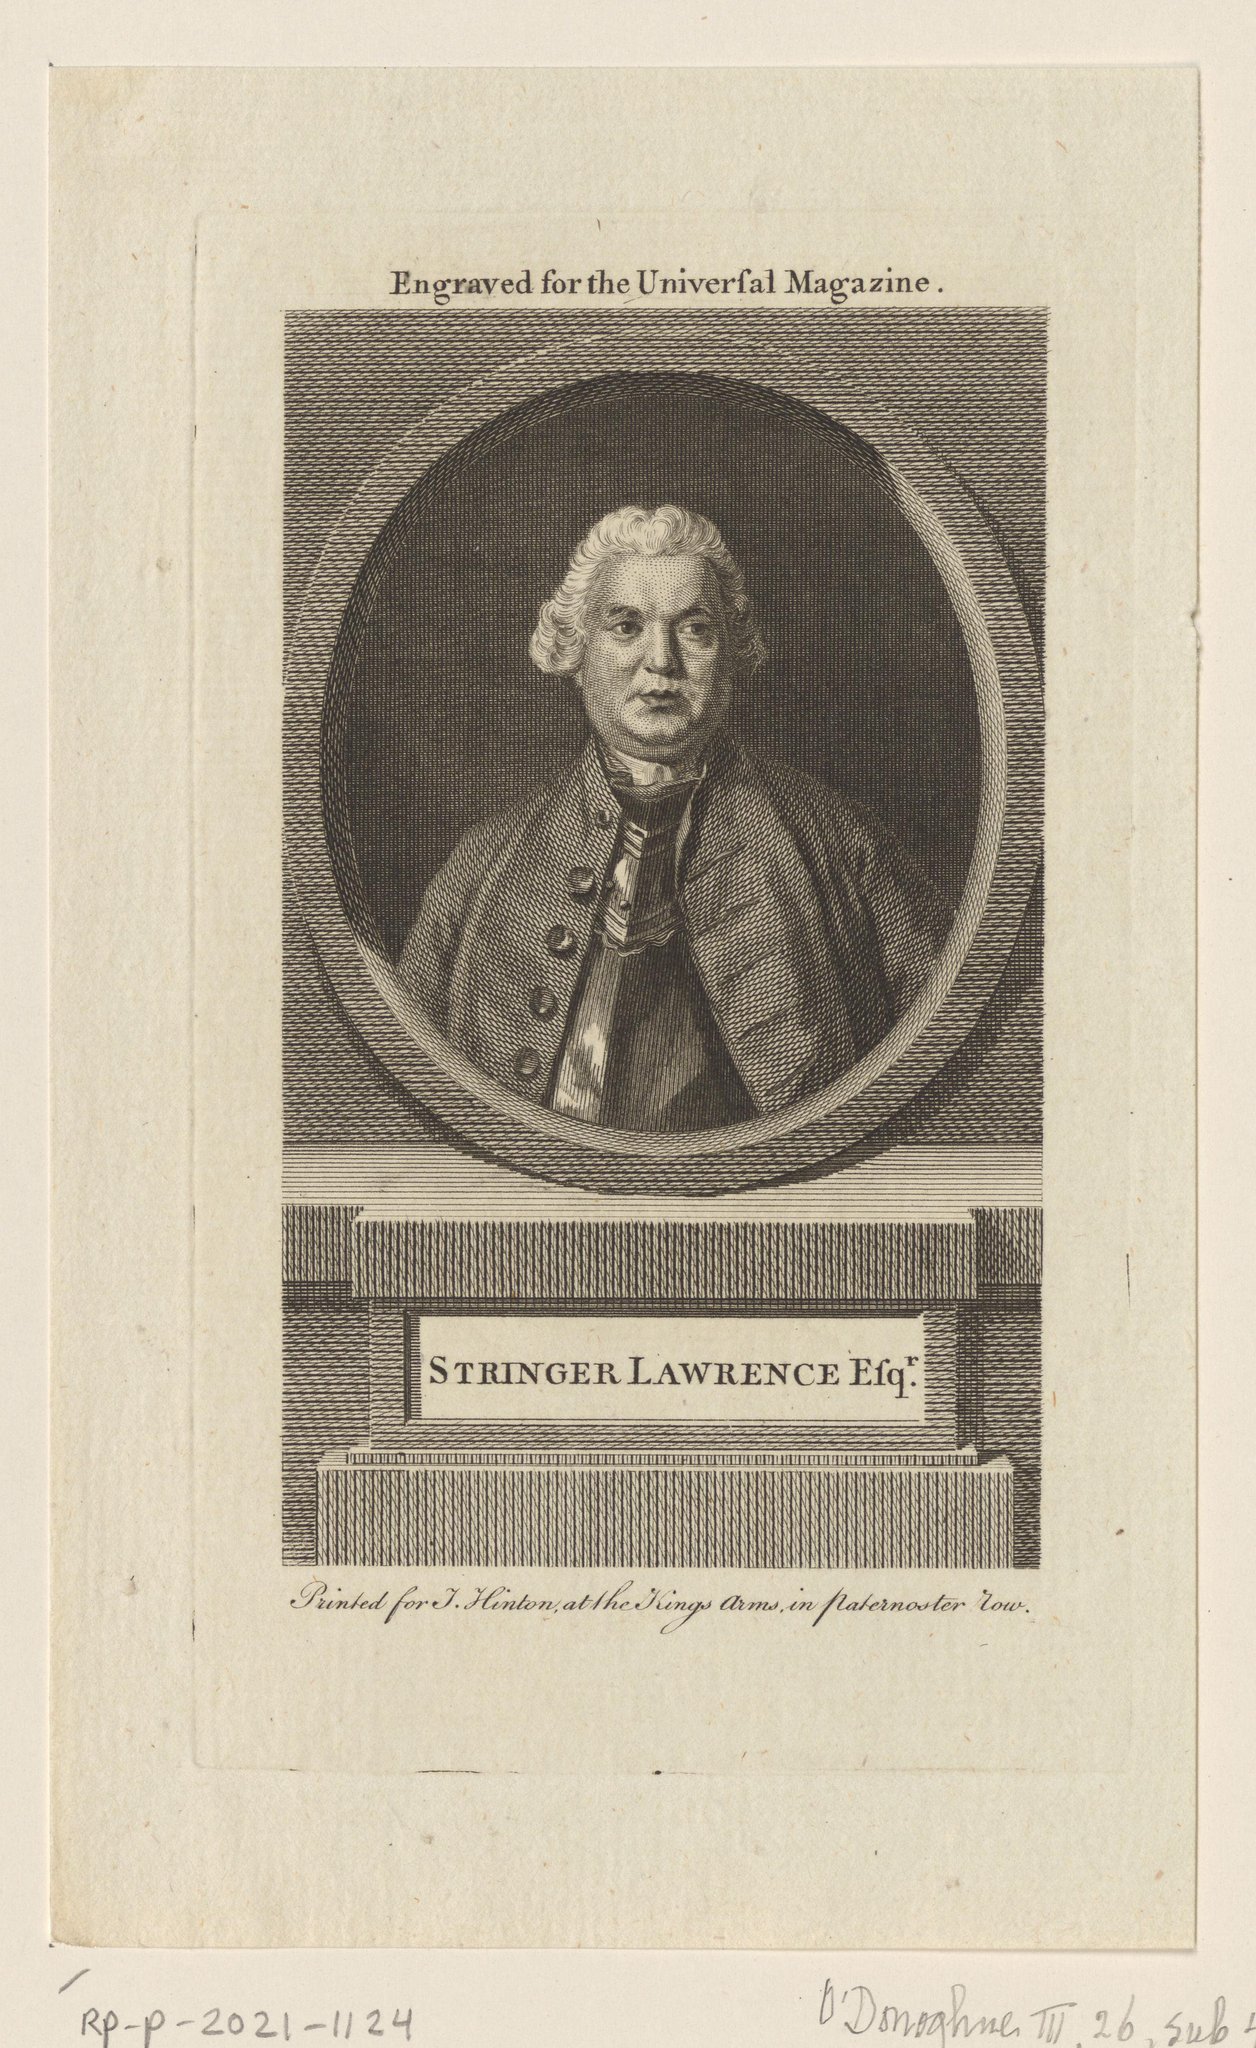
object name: print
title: Portret van Stringer Lawrence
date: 1747-1781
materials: paper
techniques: etching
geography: england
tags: london, ornament ~ medallion, commander-in-chief, general, marshal, historical persons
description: Prent komt uit een editie van The Universal Magazine.